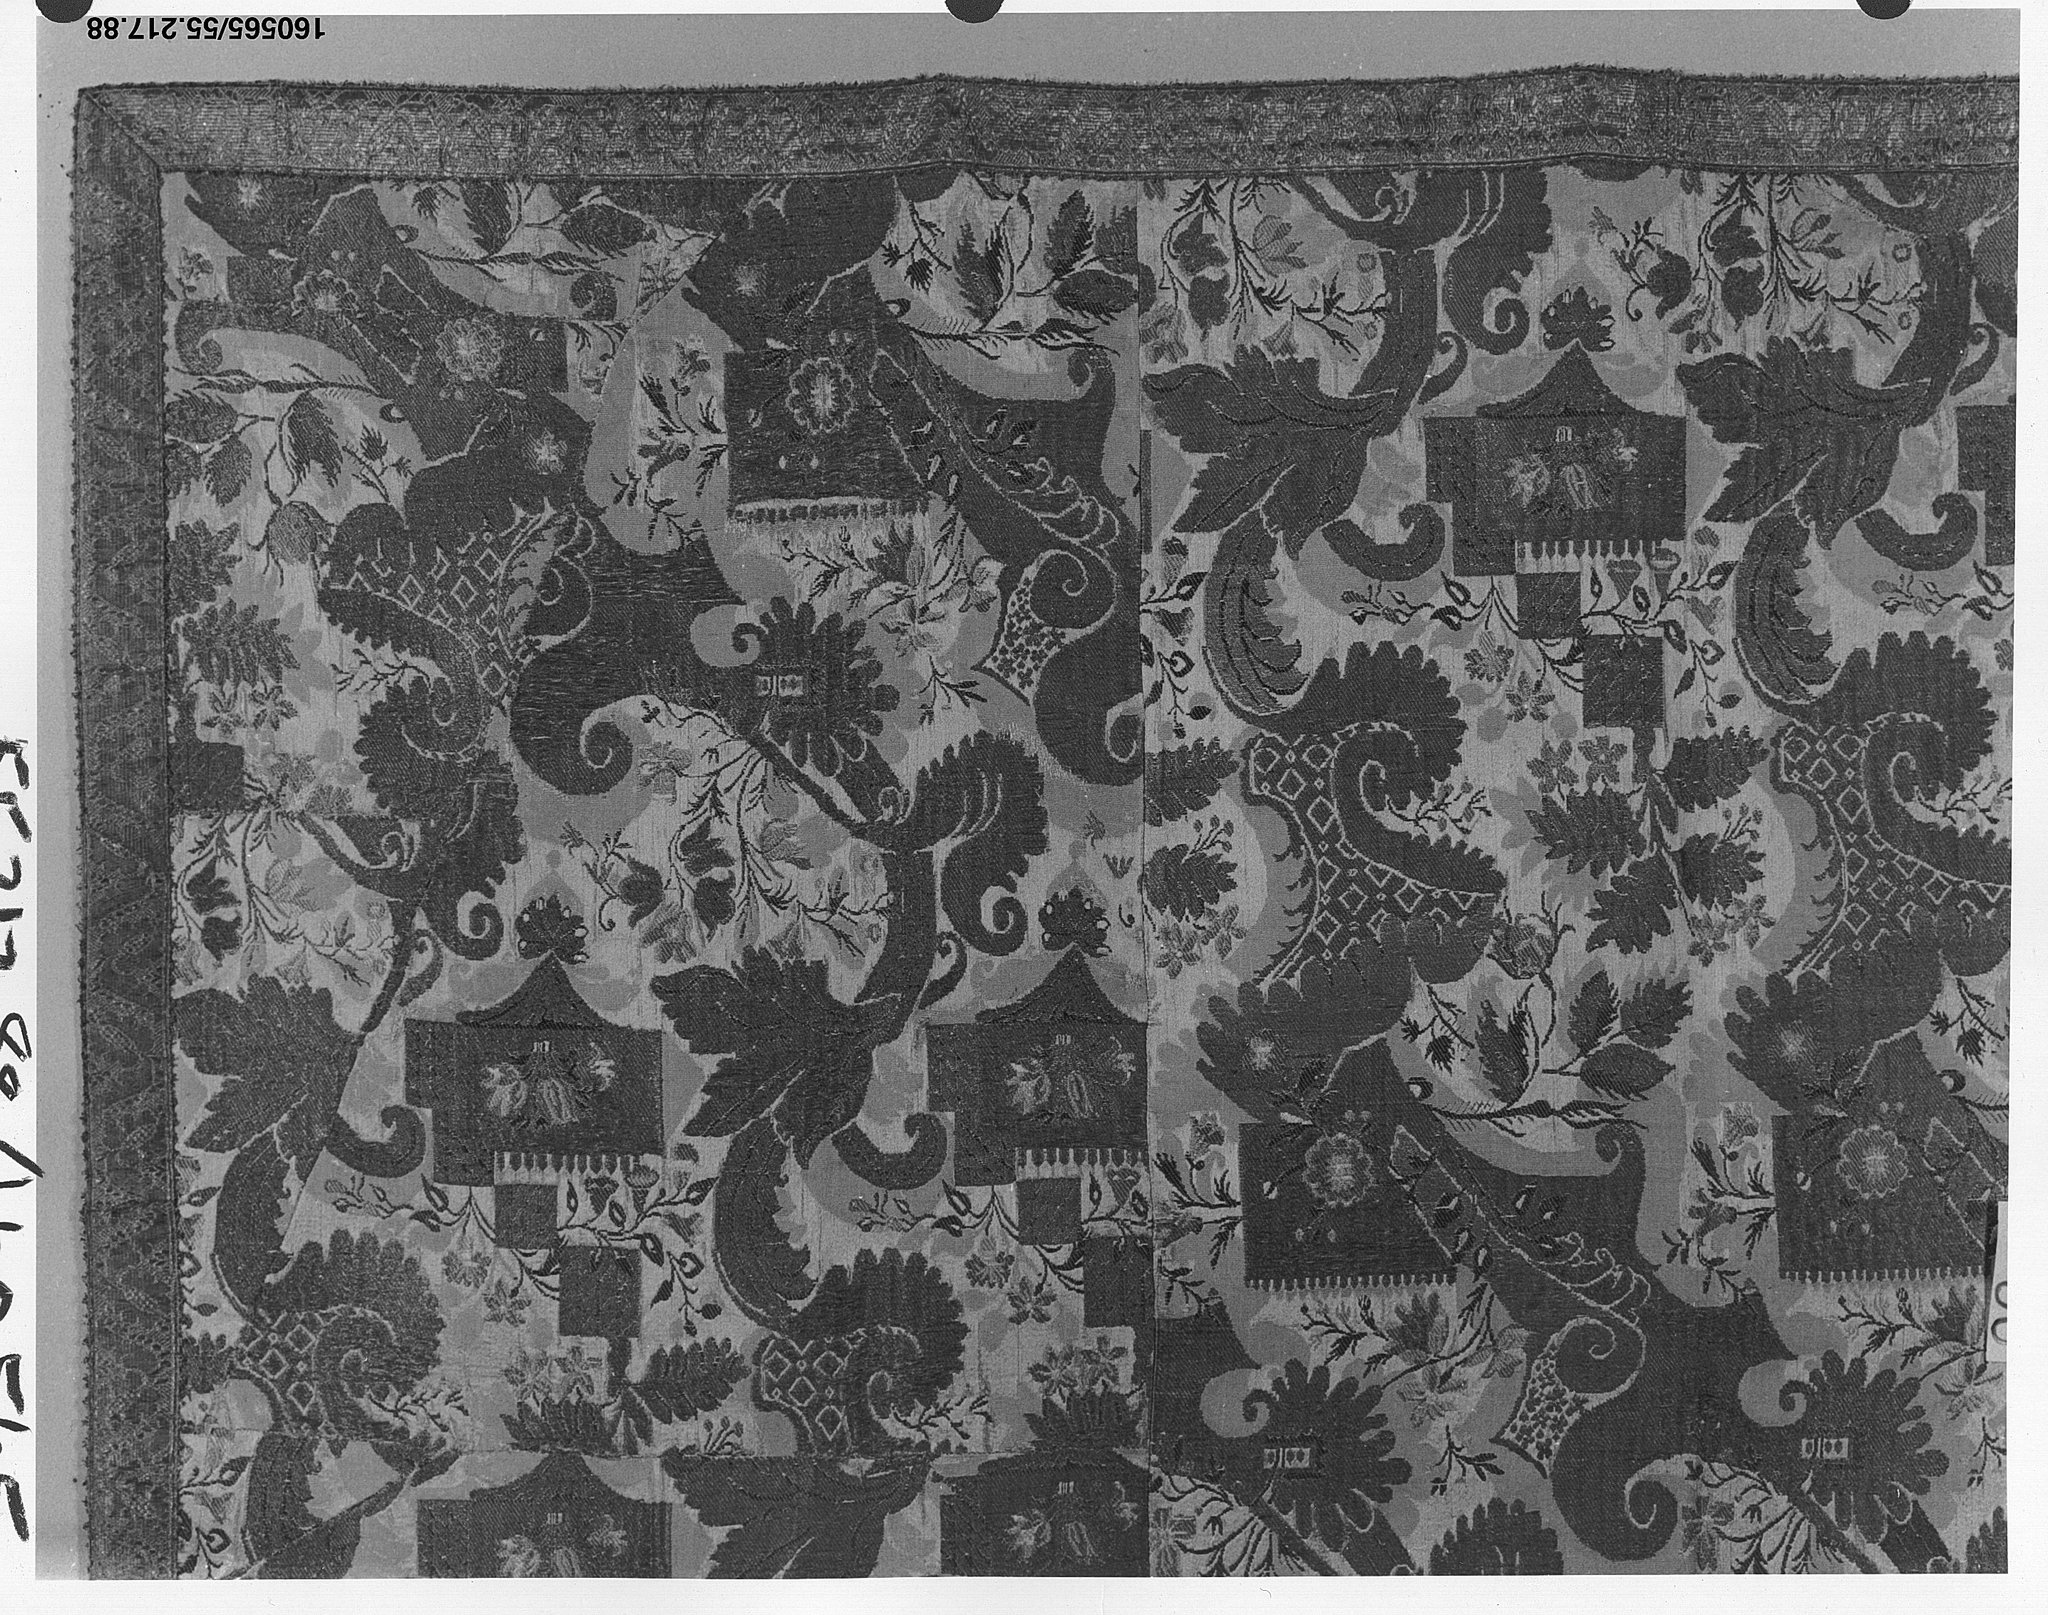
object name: piece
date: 1715-1720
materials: metal thread, silk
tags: leaves